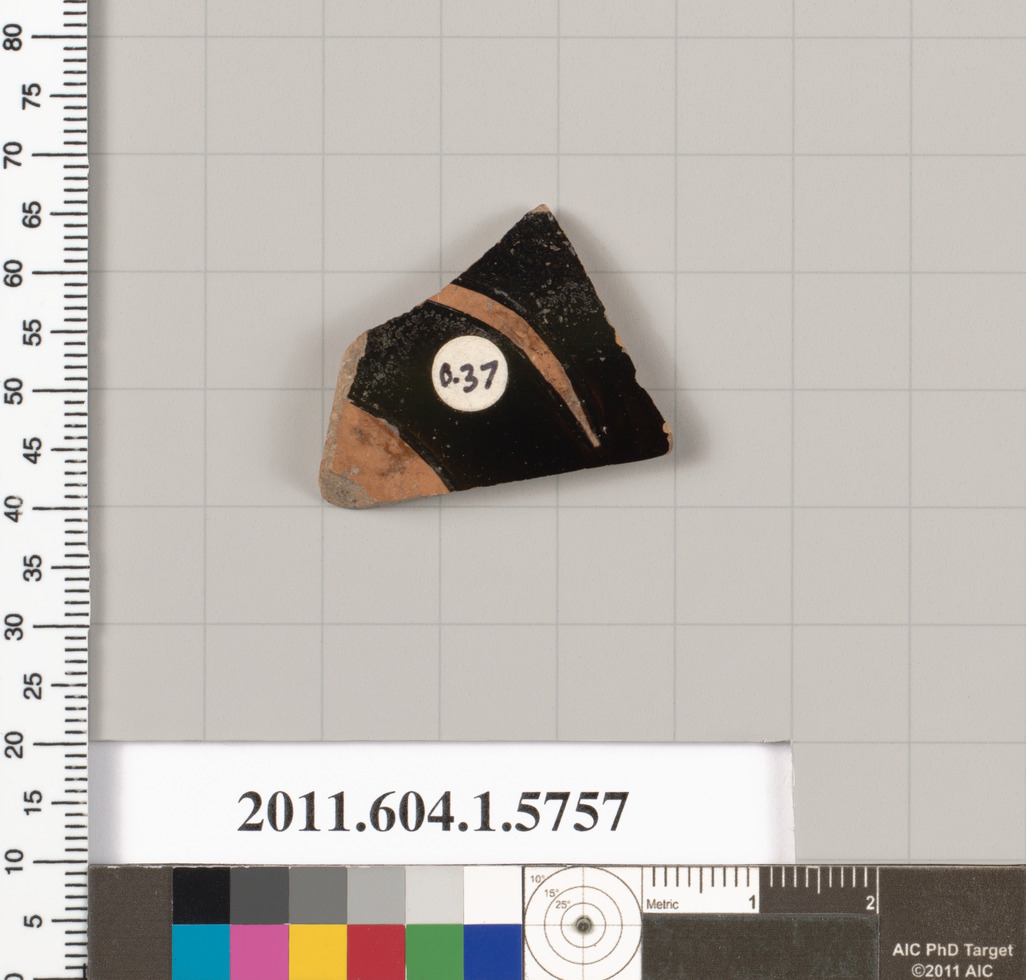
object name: kylix fragment, eye cup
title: Terracotta fragment of a kylix: eye-cup (drinking cup)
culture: greek, attic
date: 525-510 BCE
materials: terracotta